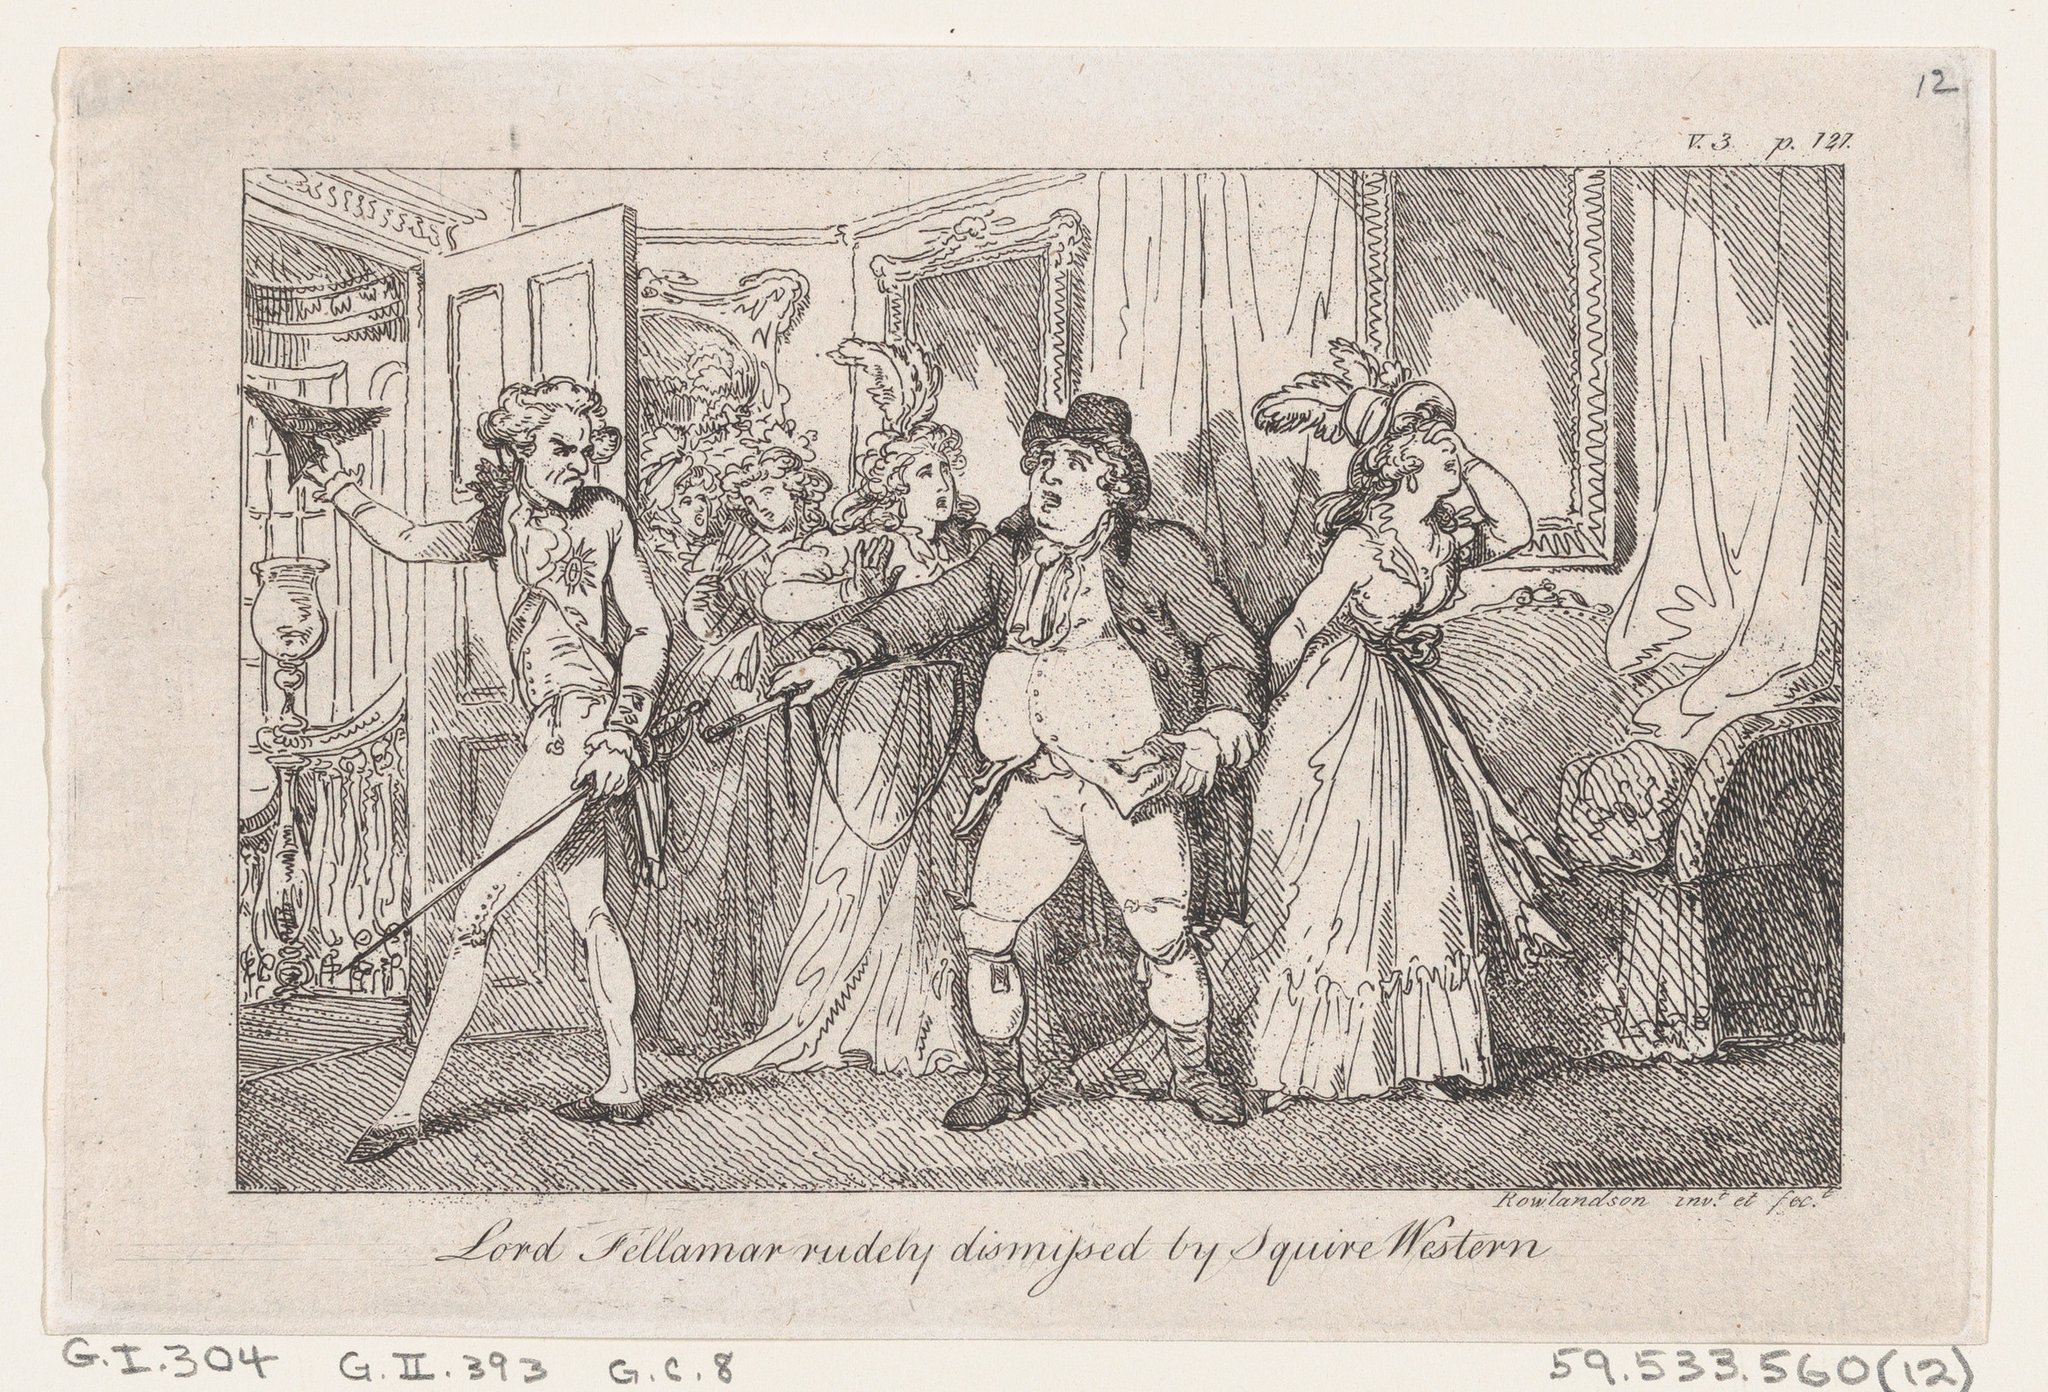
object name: print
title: Lord Tellamar Rudely Dismissed by Squire Western, from "The History of Tom Jones, a Foundling"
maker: thomas rowlandson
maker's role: artist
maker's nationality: british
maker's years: 1757-1827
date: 1792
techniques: etching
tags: men,women